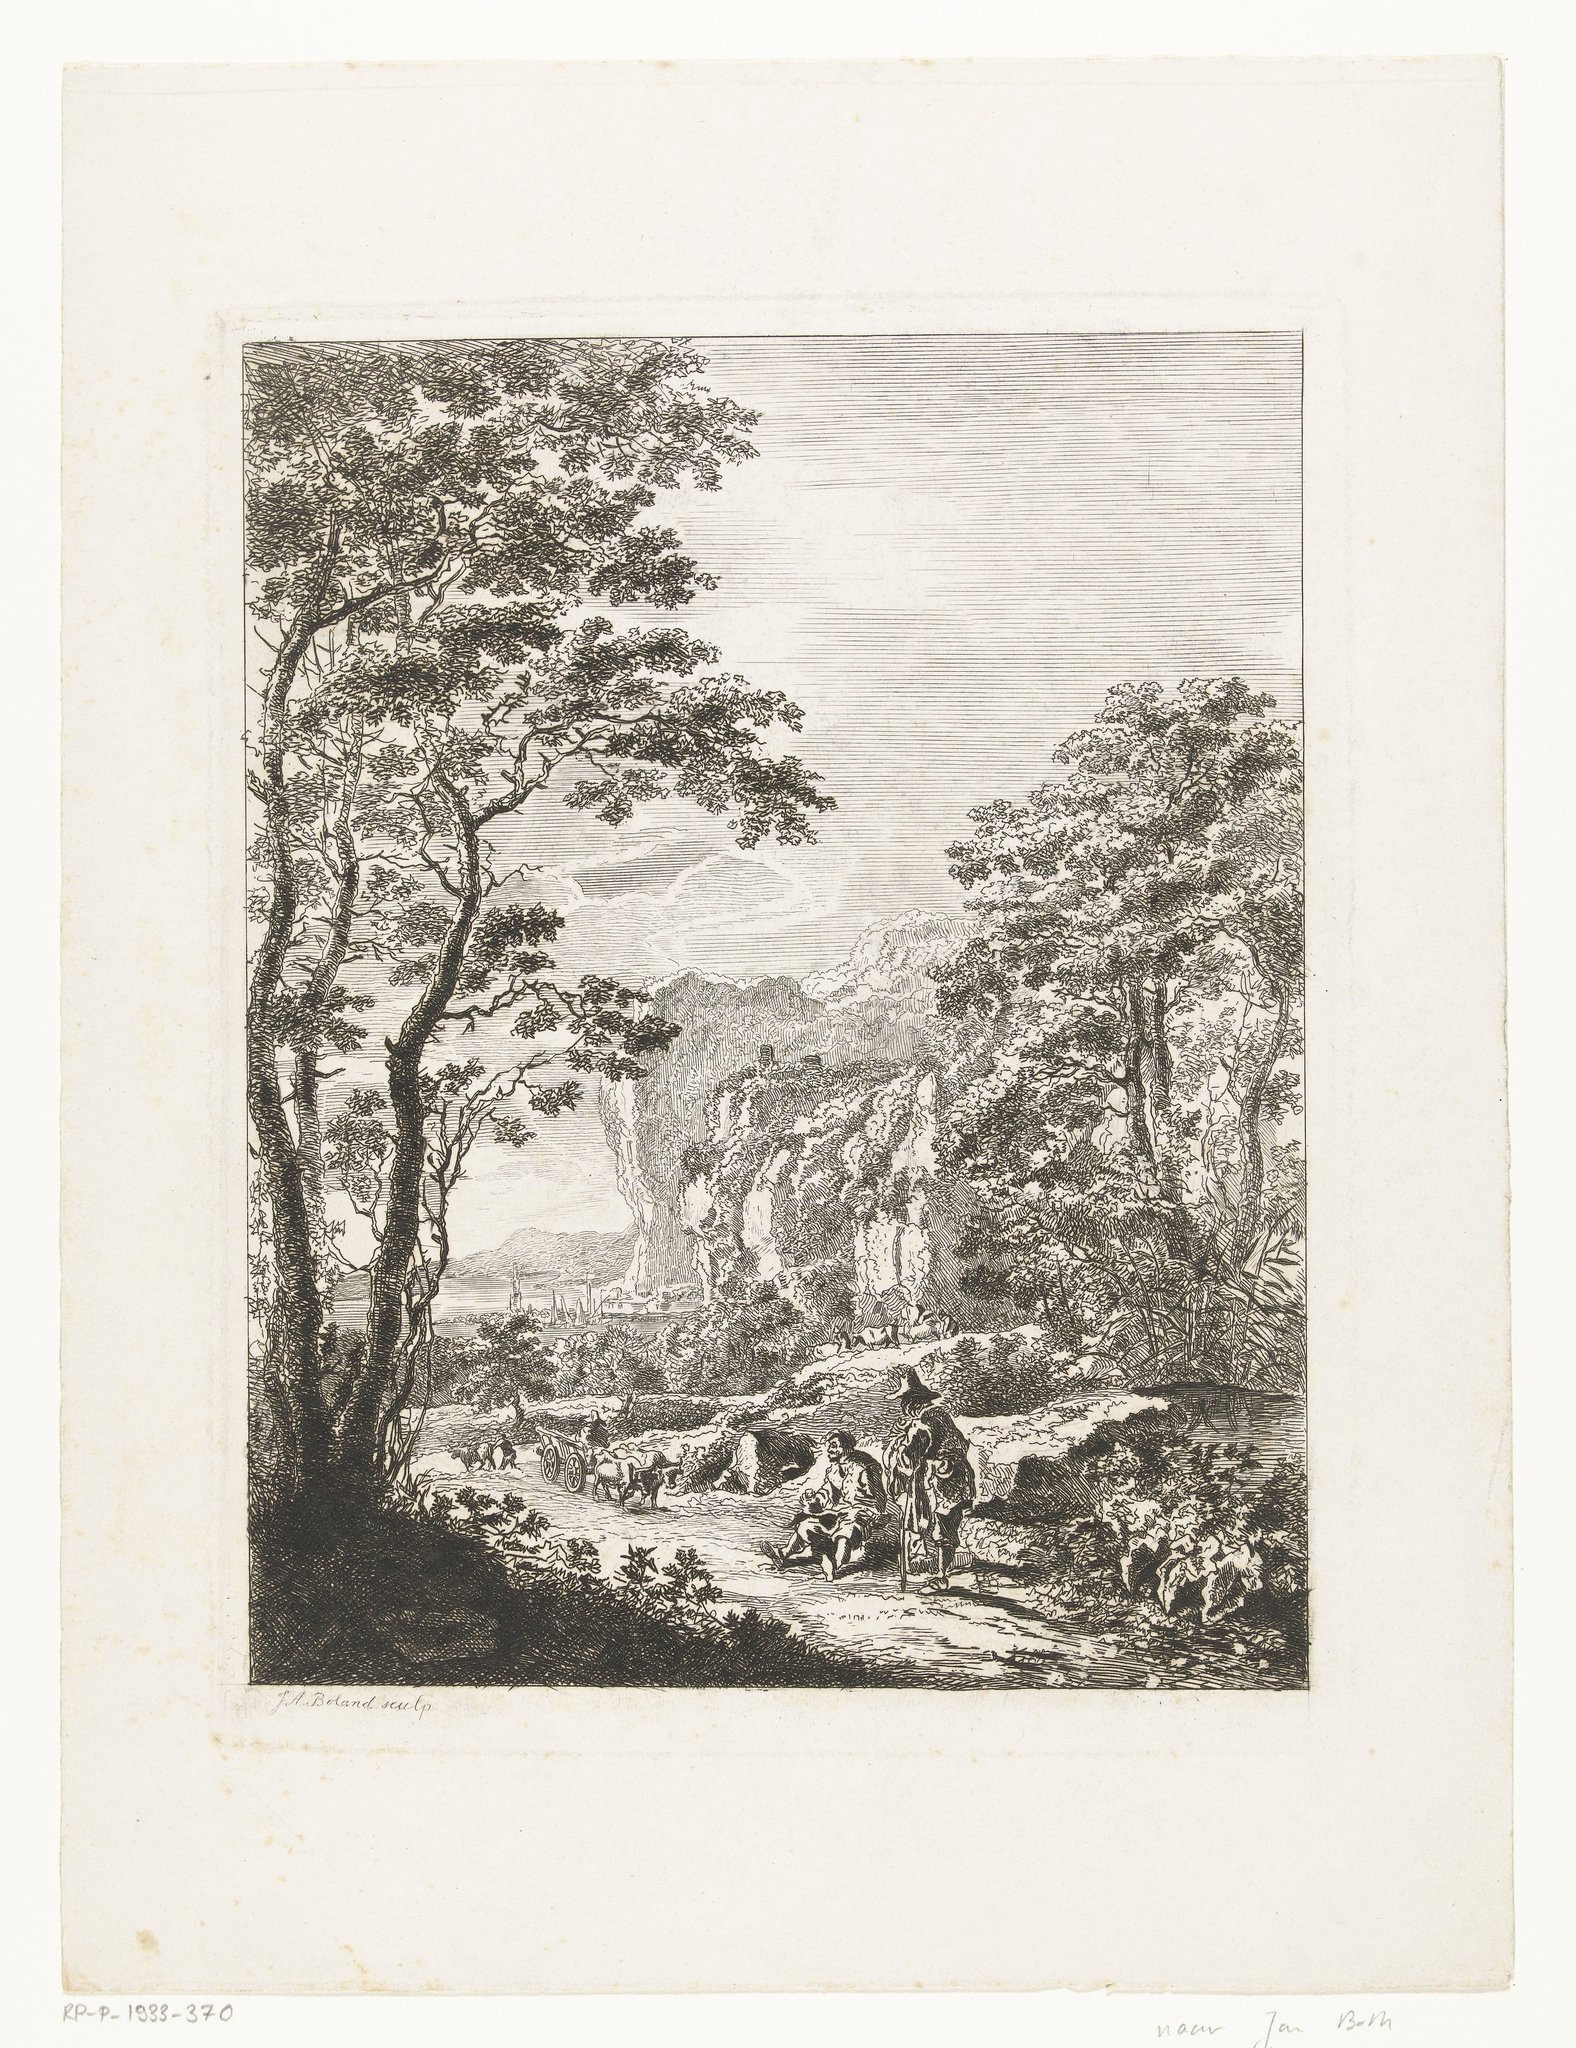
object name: print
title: Landschap met een ossewagen, gezicht tussen Ancona en Senigallia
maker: johannes arnoldus boland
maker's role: print maker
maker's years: 1838-1922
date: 1860-1900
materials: paper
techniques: etching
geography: amsterdam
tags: ox, rocks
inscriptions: collector's mark: Lugt 2228